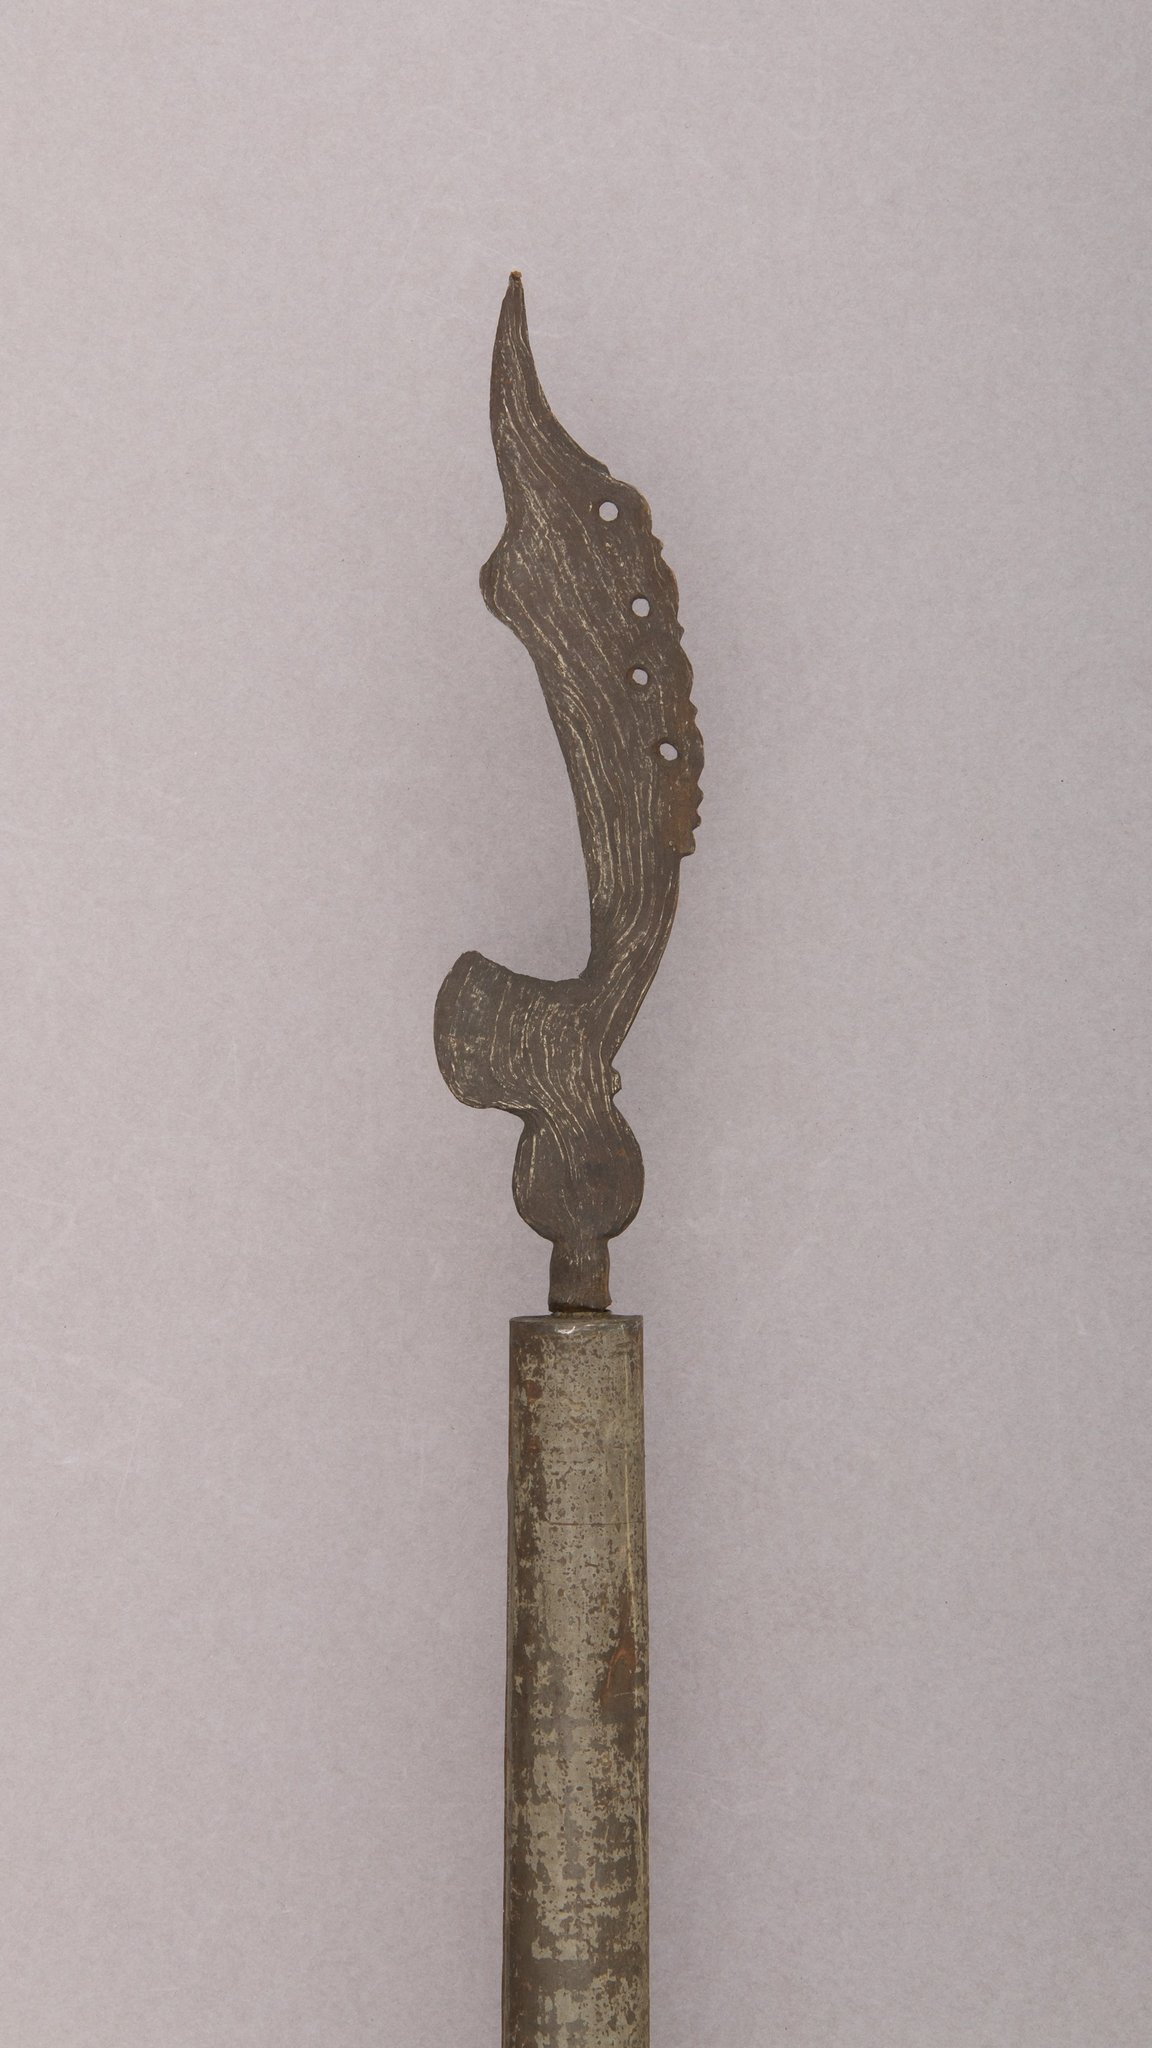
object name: spear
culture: javanese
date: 1501-1900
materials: brass, tin, wood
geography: indonesia